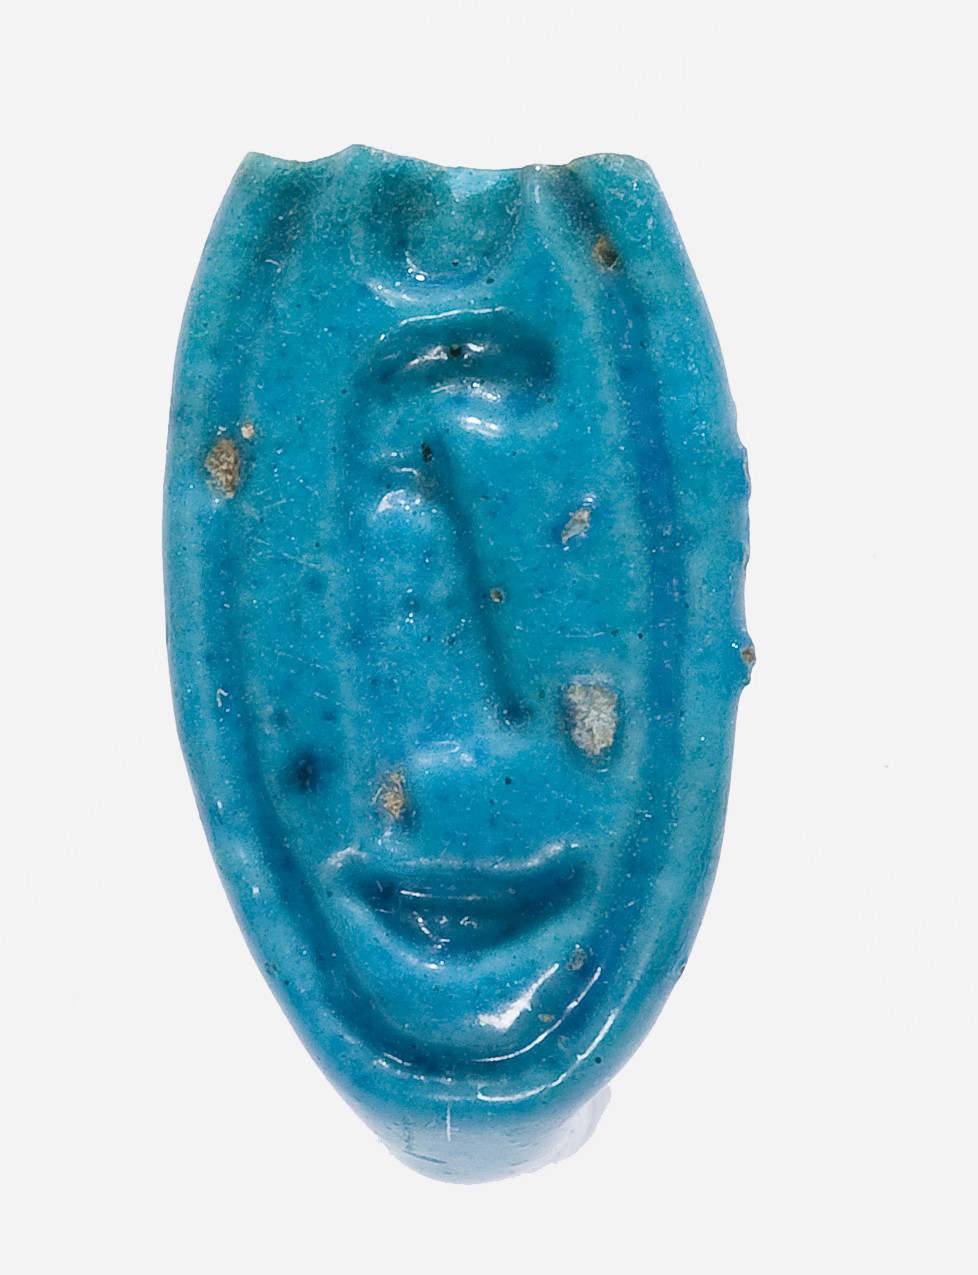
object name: ring, amenhotep iii prenomen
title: Ring, Prenomen of Amenhotep III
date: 1390-1352 BCE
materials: faience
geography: egypt